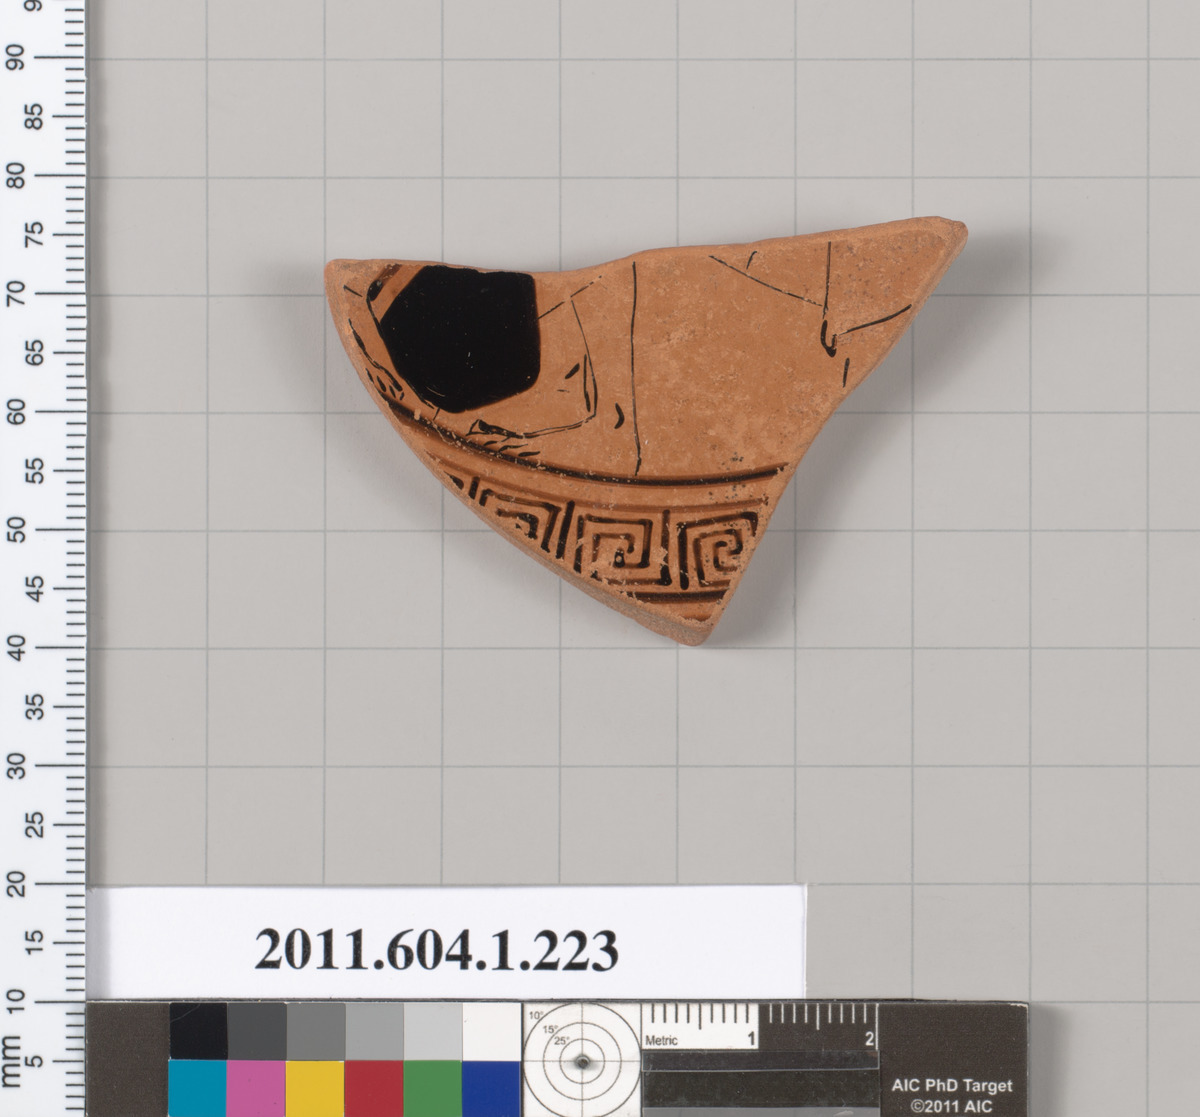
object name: kylix fragment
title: Terracotta fragment of a kylix (drinking cup)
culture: greek, attic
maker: painter of brussels r 330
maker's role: artist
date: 475-451 BCE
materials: terracotta